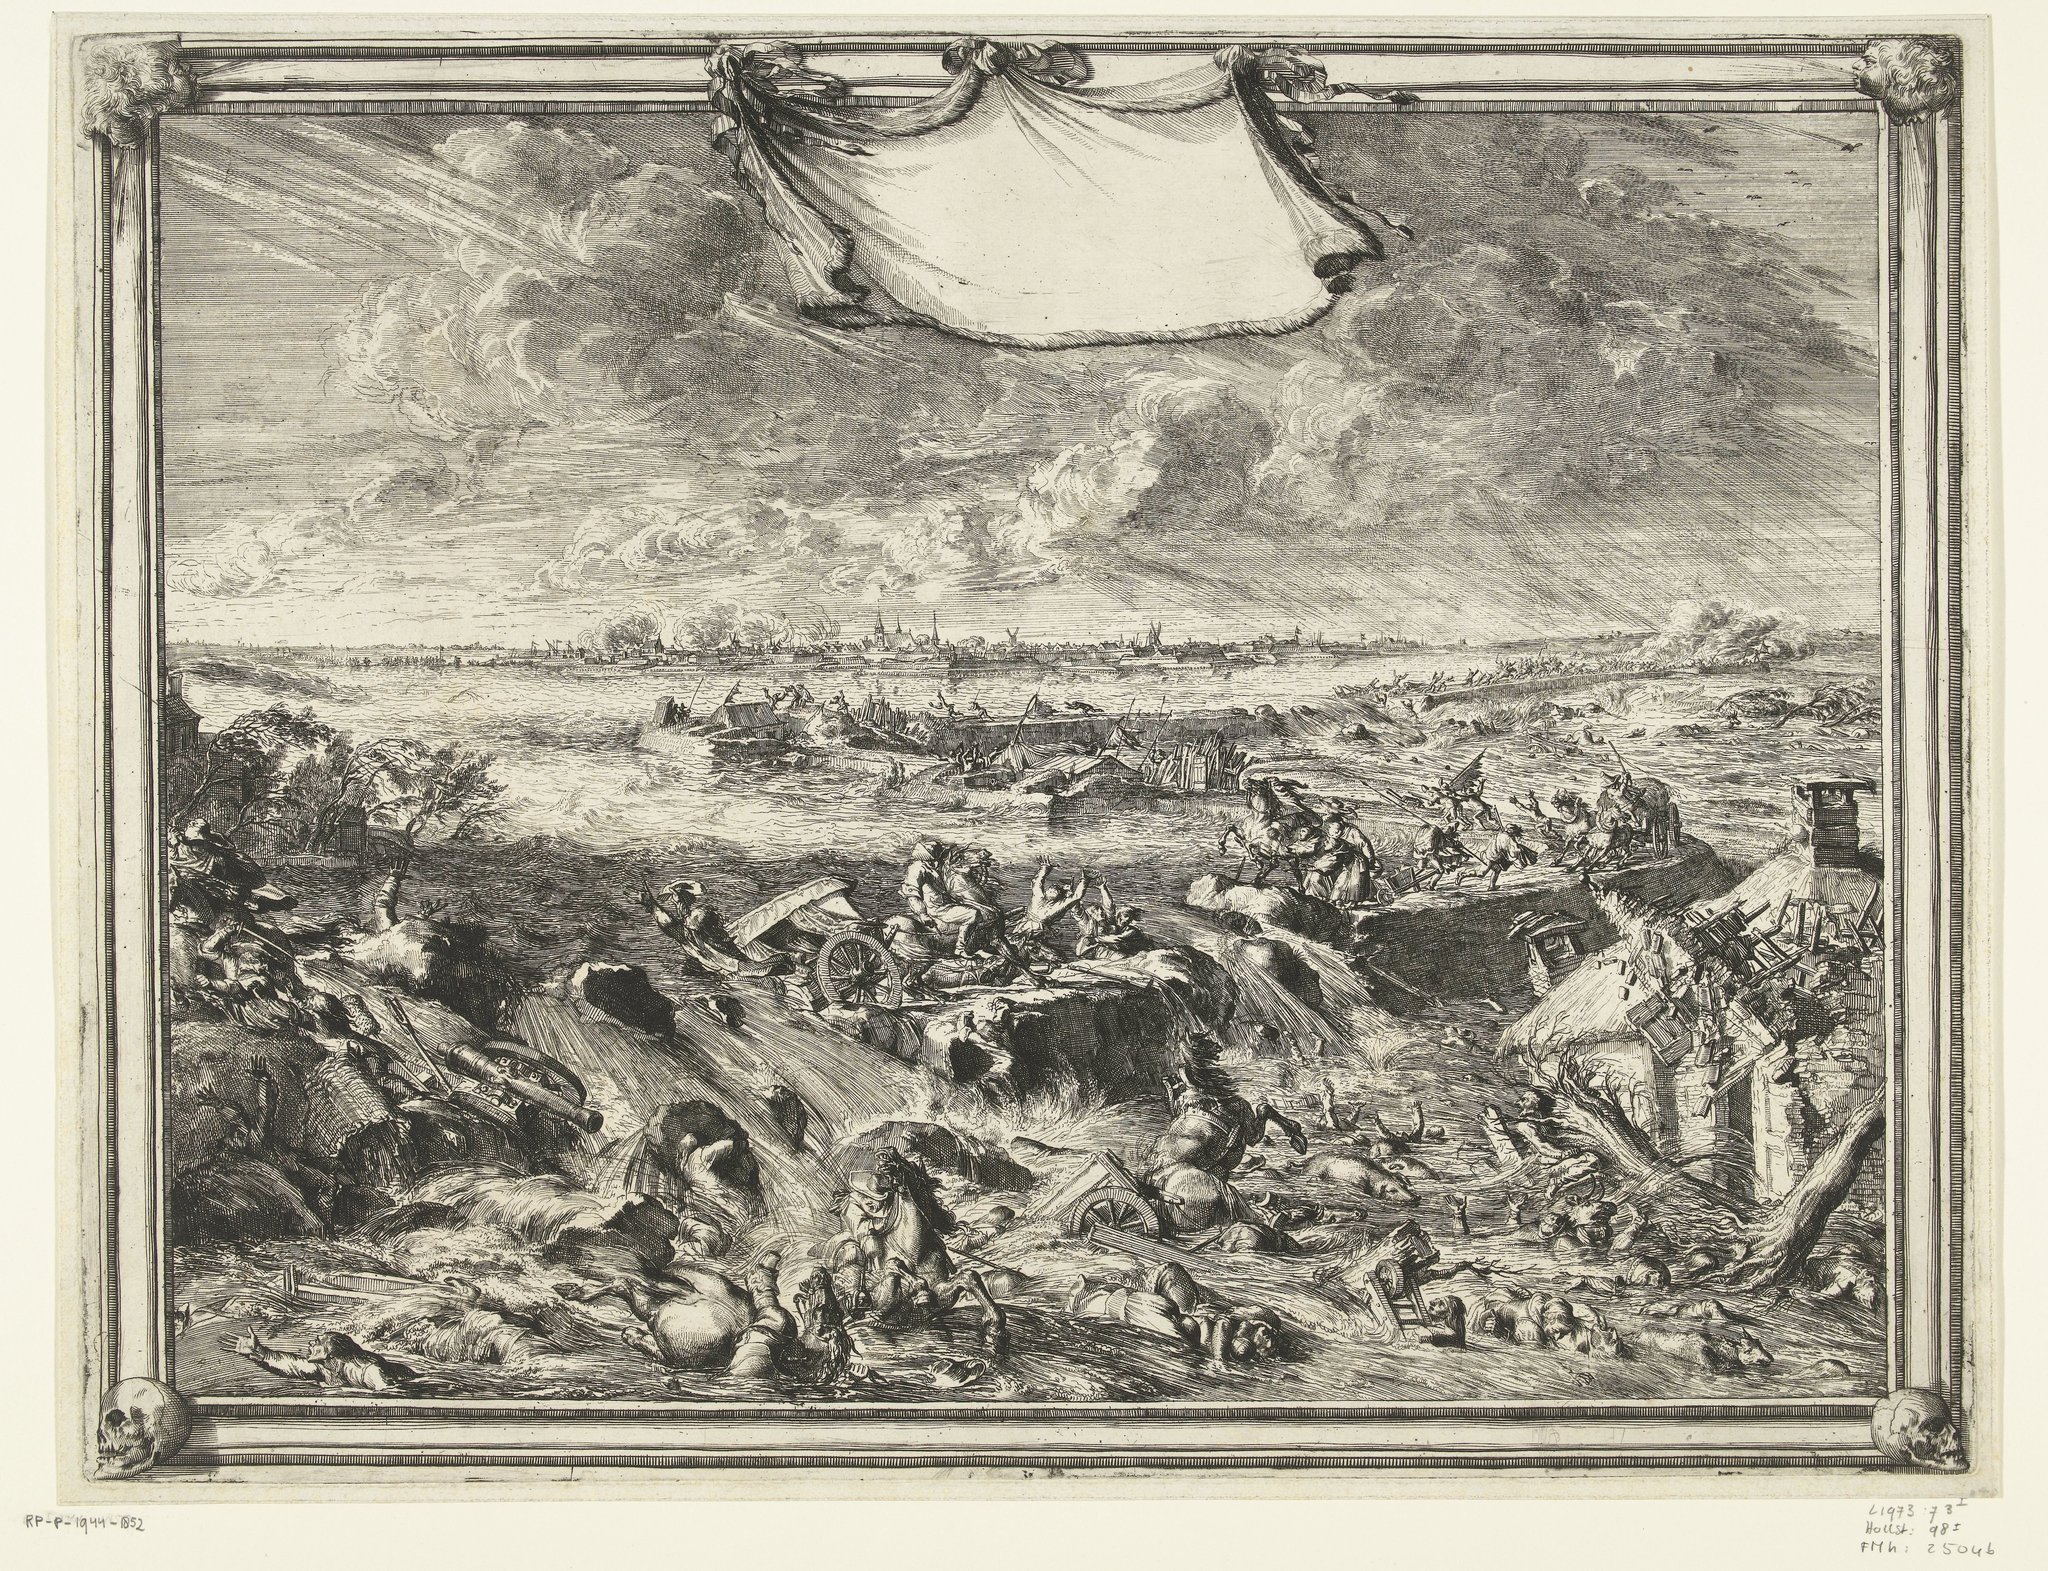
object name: print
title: Dijkdoorbraak bij Coevorden, 1673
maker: romeyn de hooghe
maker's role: draughtsman, goldsmith, painter, print maker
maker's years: 1645-1708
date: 1673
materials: paper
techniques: engraving, etching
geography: northern netherlands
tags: dike-break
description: Dijkdoorbraak bij Coevorden, 1 oktober 1673. Vijandelijke ruiters en geschut worden door het water weggespoeld, in de verte de stad Coevorden. Bovenin de plaat de titel op een hangende doek, links een legenda 1-11, rechts een vers van 6 regels 'Op Coeverdens Miraculeuse Verlossinge'. Het geheel in een omlijsting met windkopjes en schedels.